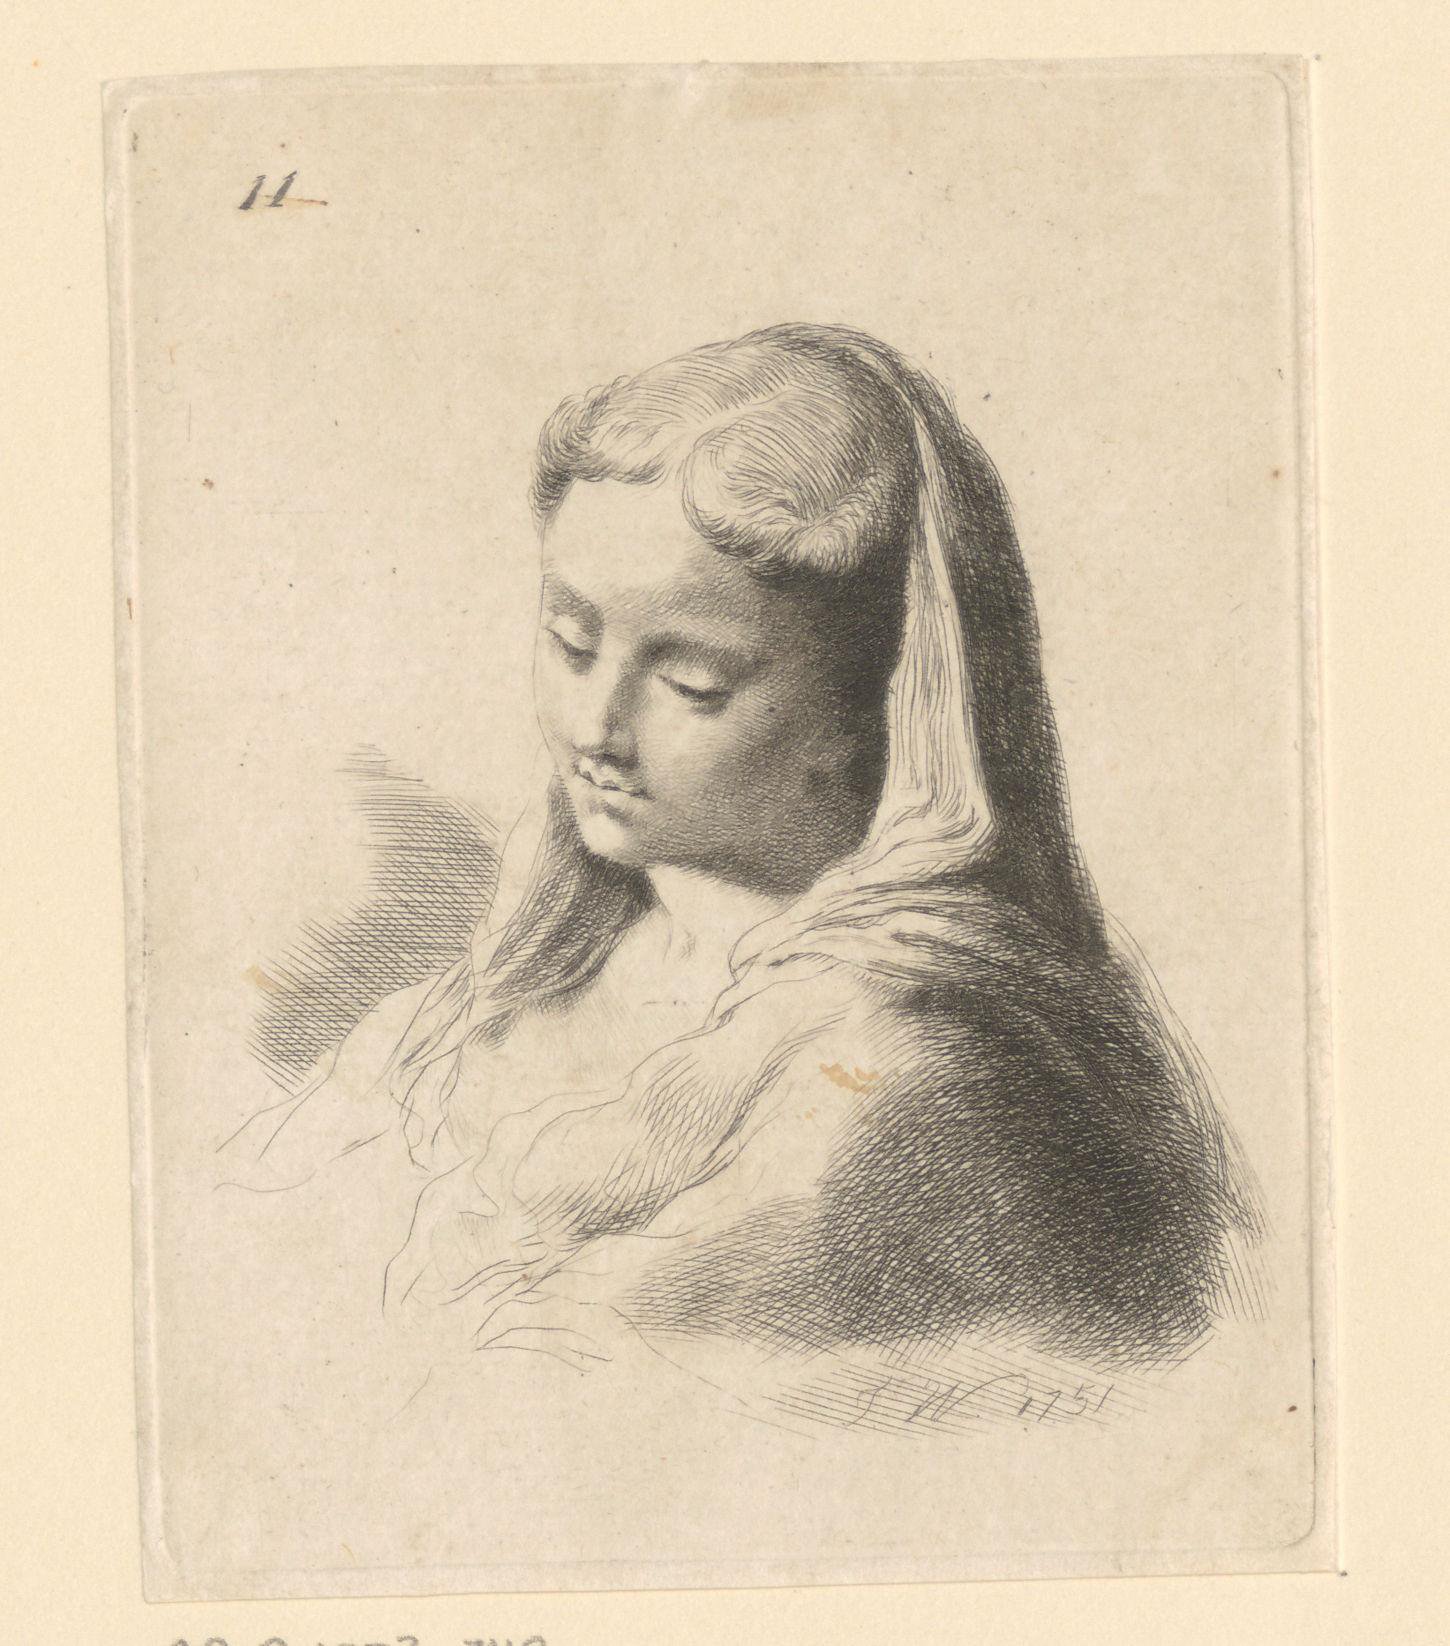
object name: print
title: Hoofd van vrouw met sluier, naar beneden kijkend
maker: thomas worlidge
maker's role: print maker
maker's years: 1700-1766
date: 1751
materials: paper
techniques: drypoint, etching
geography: london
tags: veil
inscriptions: collector's mark: Lugt 2228, collector's mark: Lugt 2760